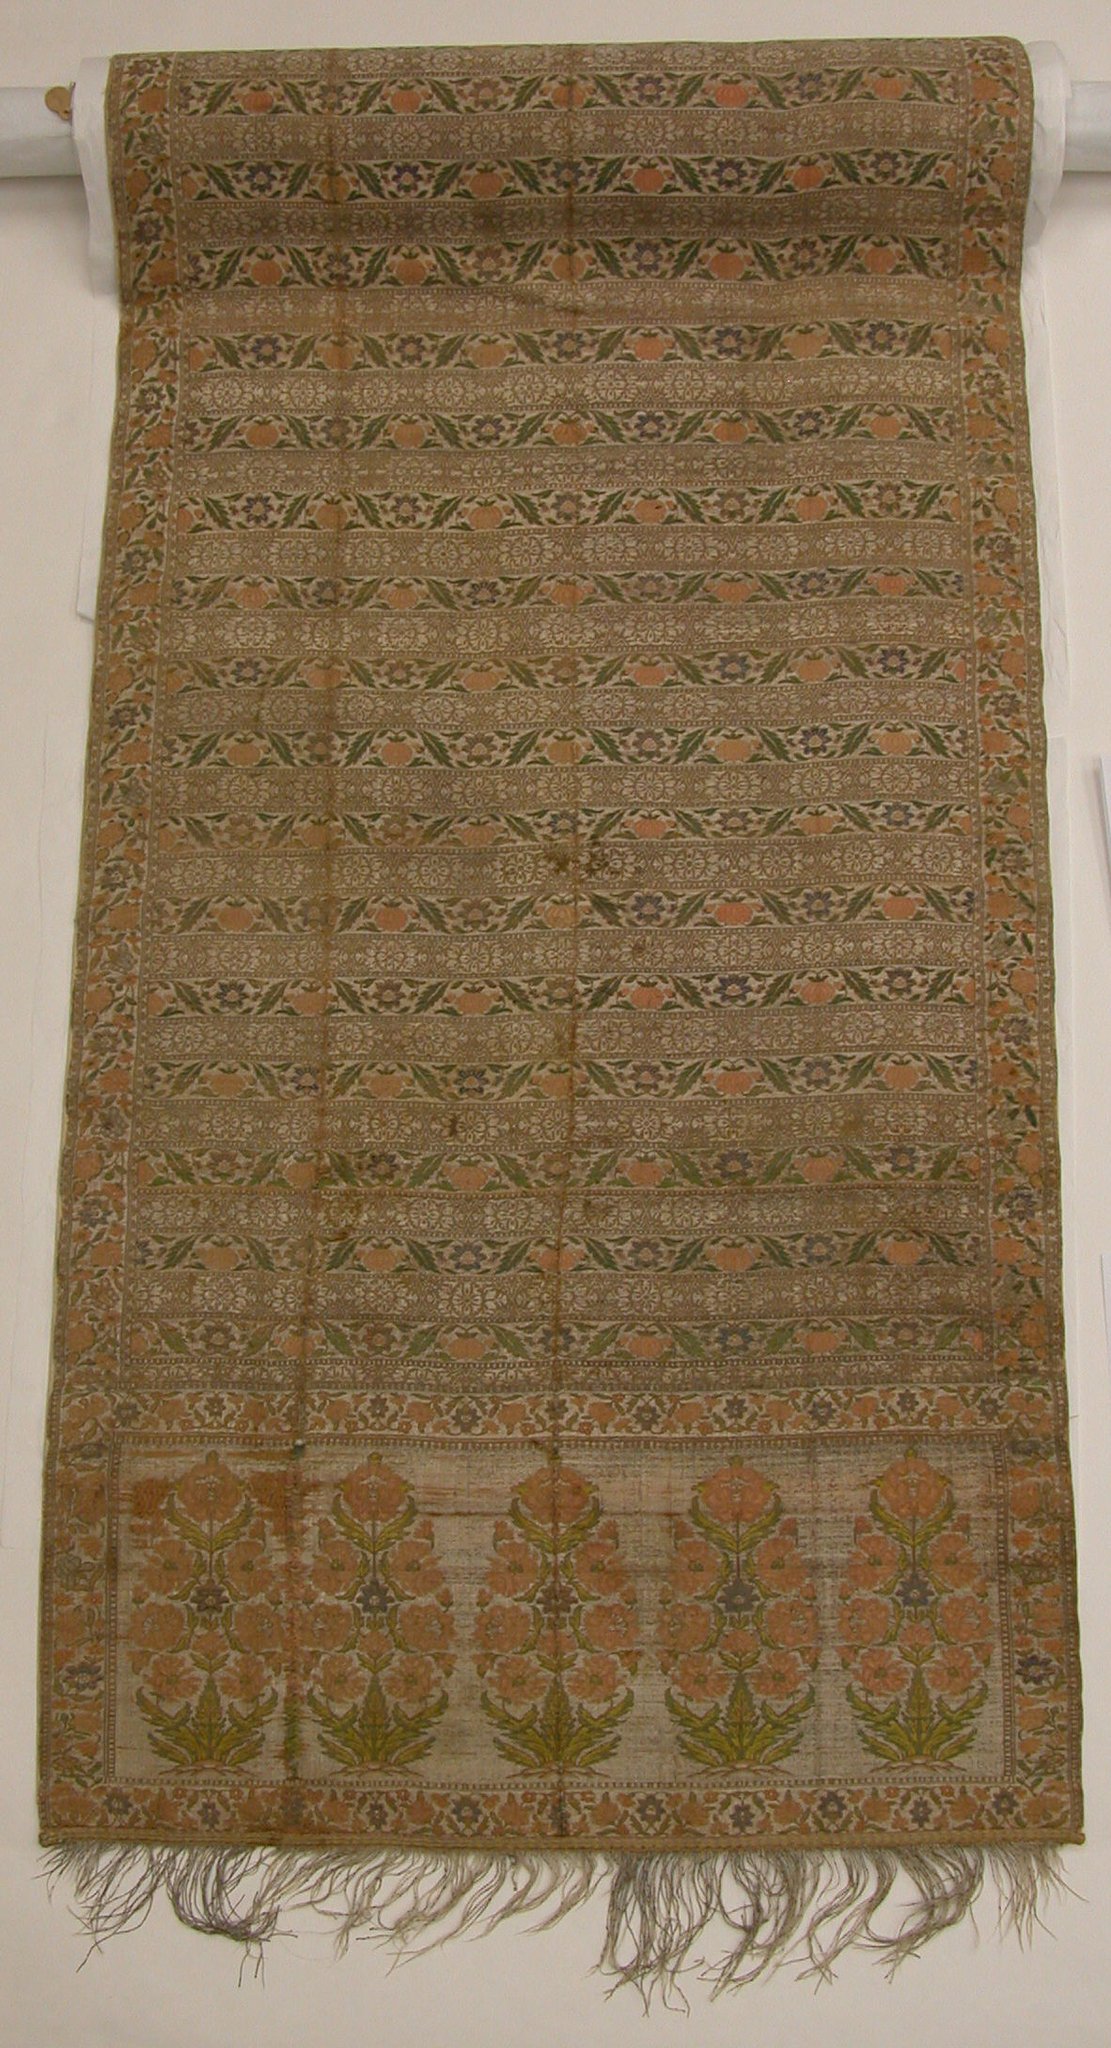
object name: sash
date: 1601-1800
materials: metal thread, silk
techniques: brocade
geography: iran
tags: flowers